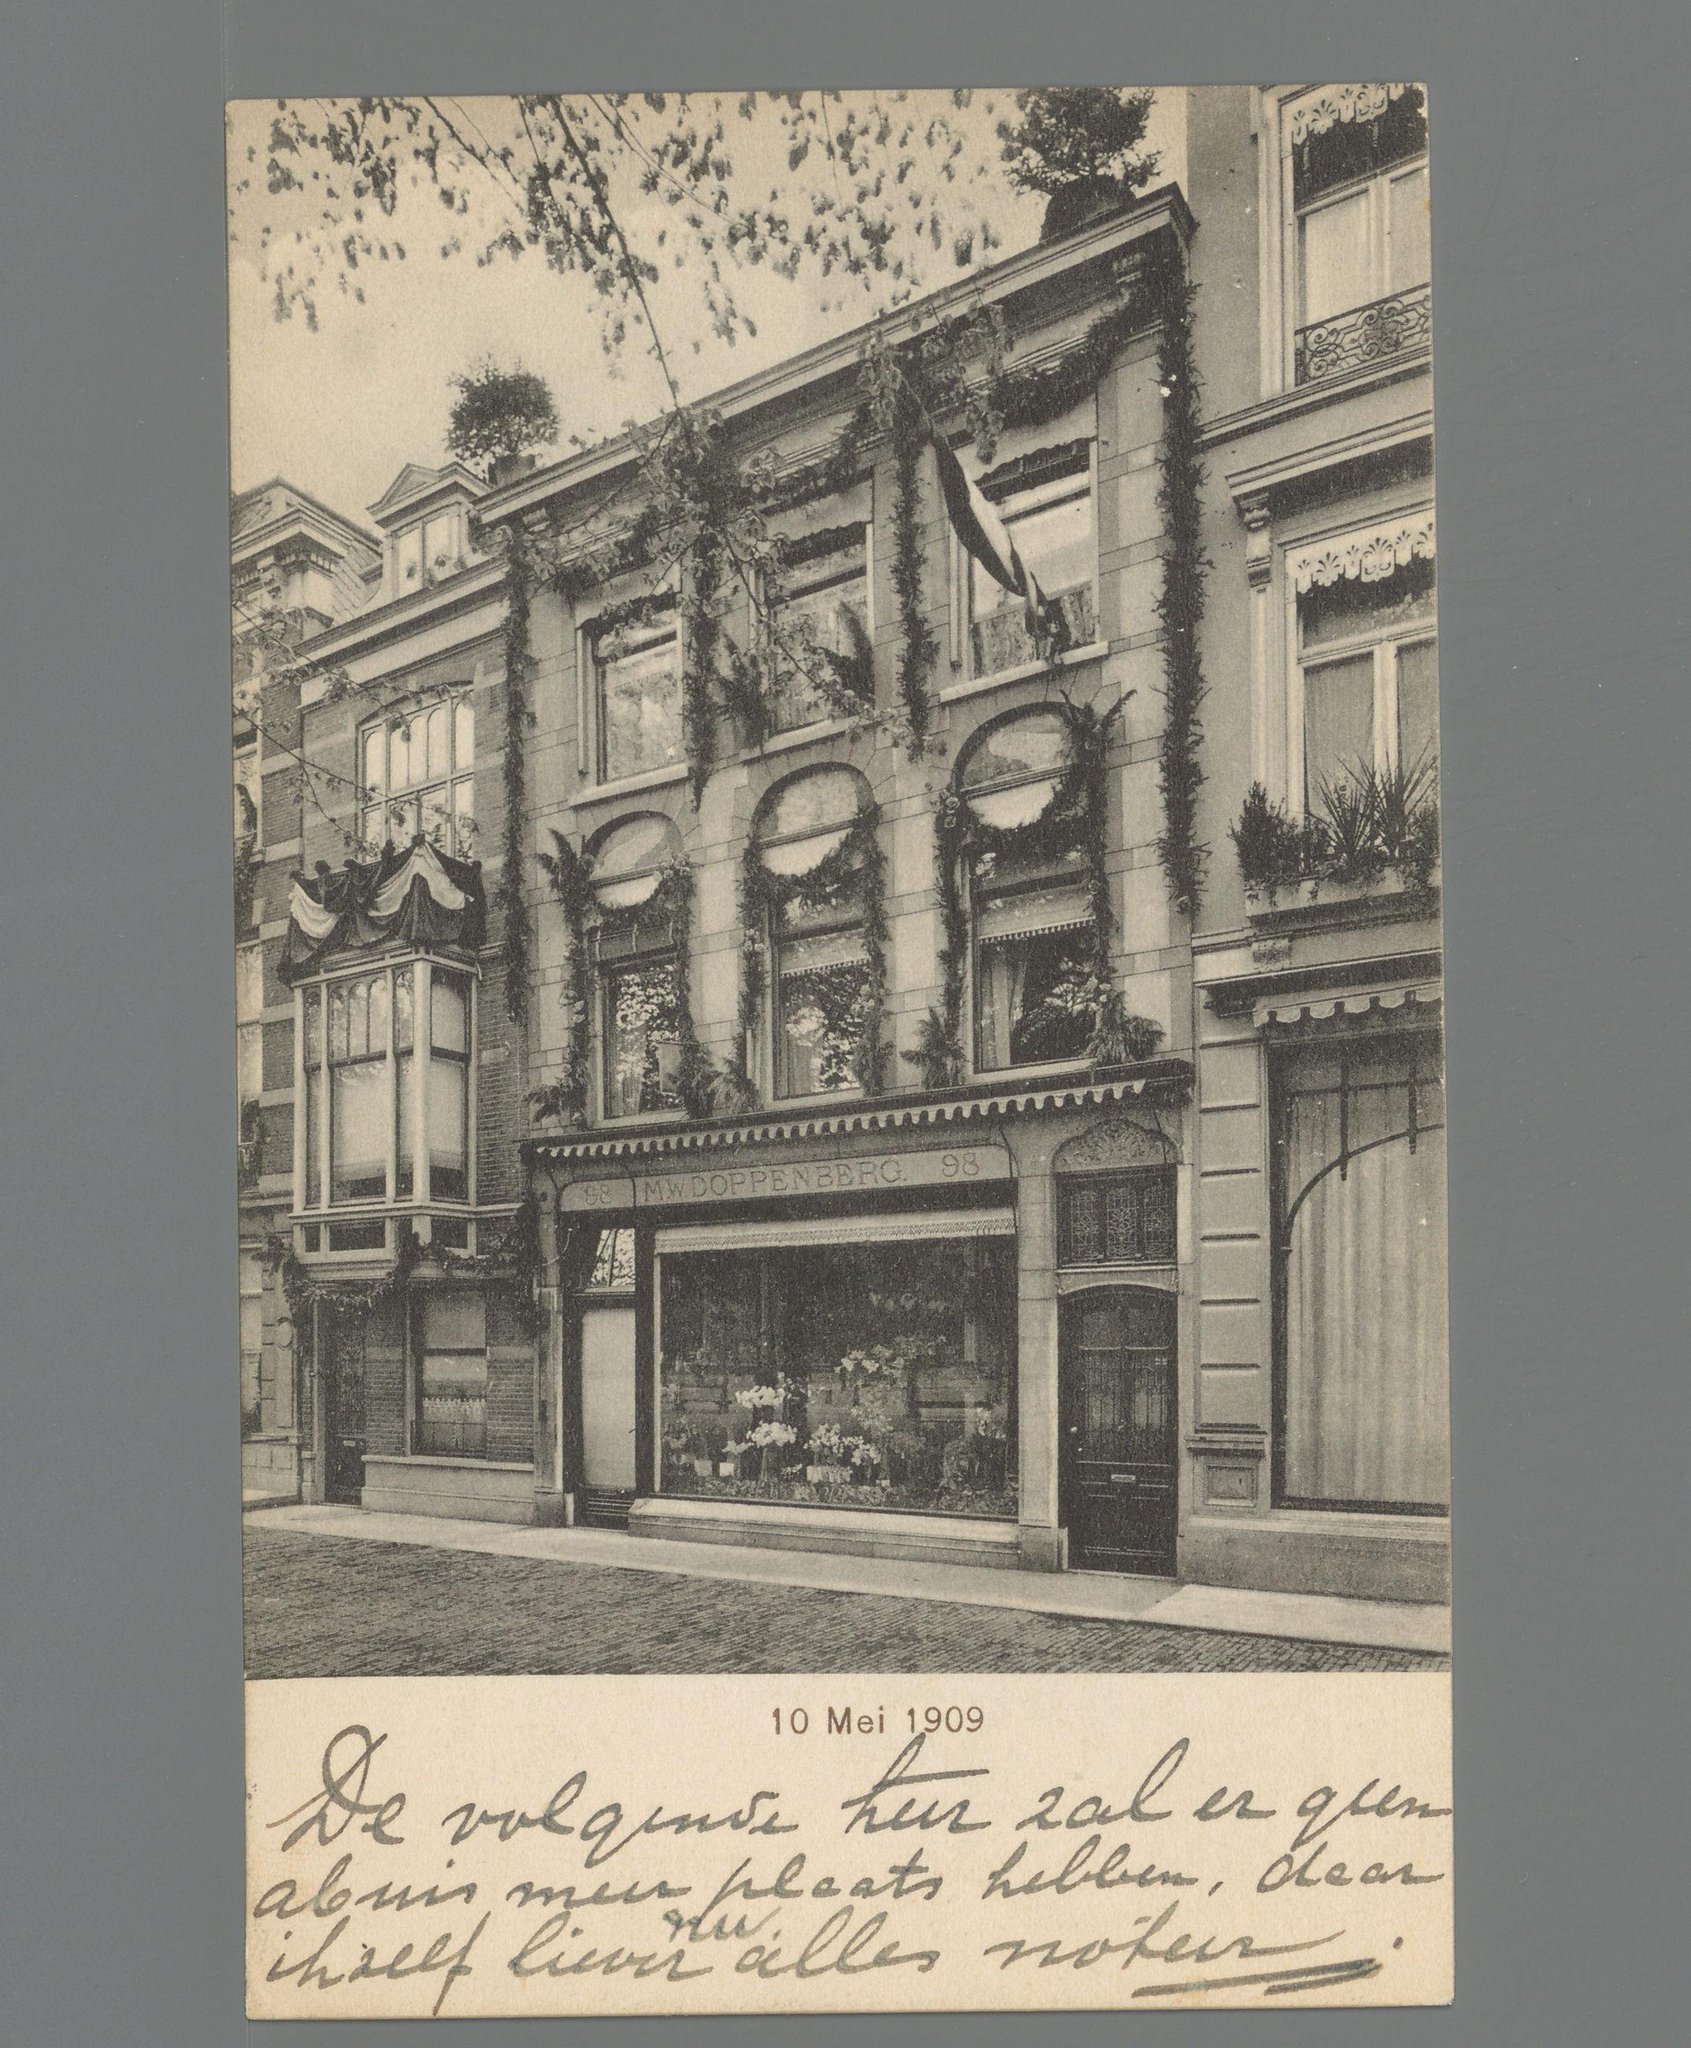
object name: photomechanical print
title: 10 Mei 1909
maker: Anonymous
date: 1909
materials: cardboard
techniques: photograph, writing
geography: the hague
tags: shop, store, flowers, street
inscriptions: postage stamp